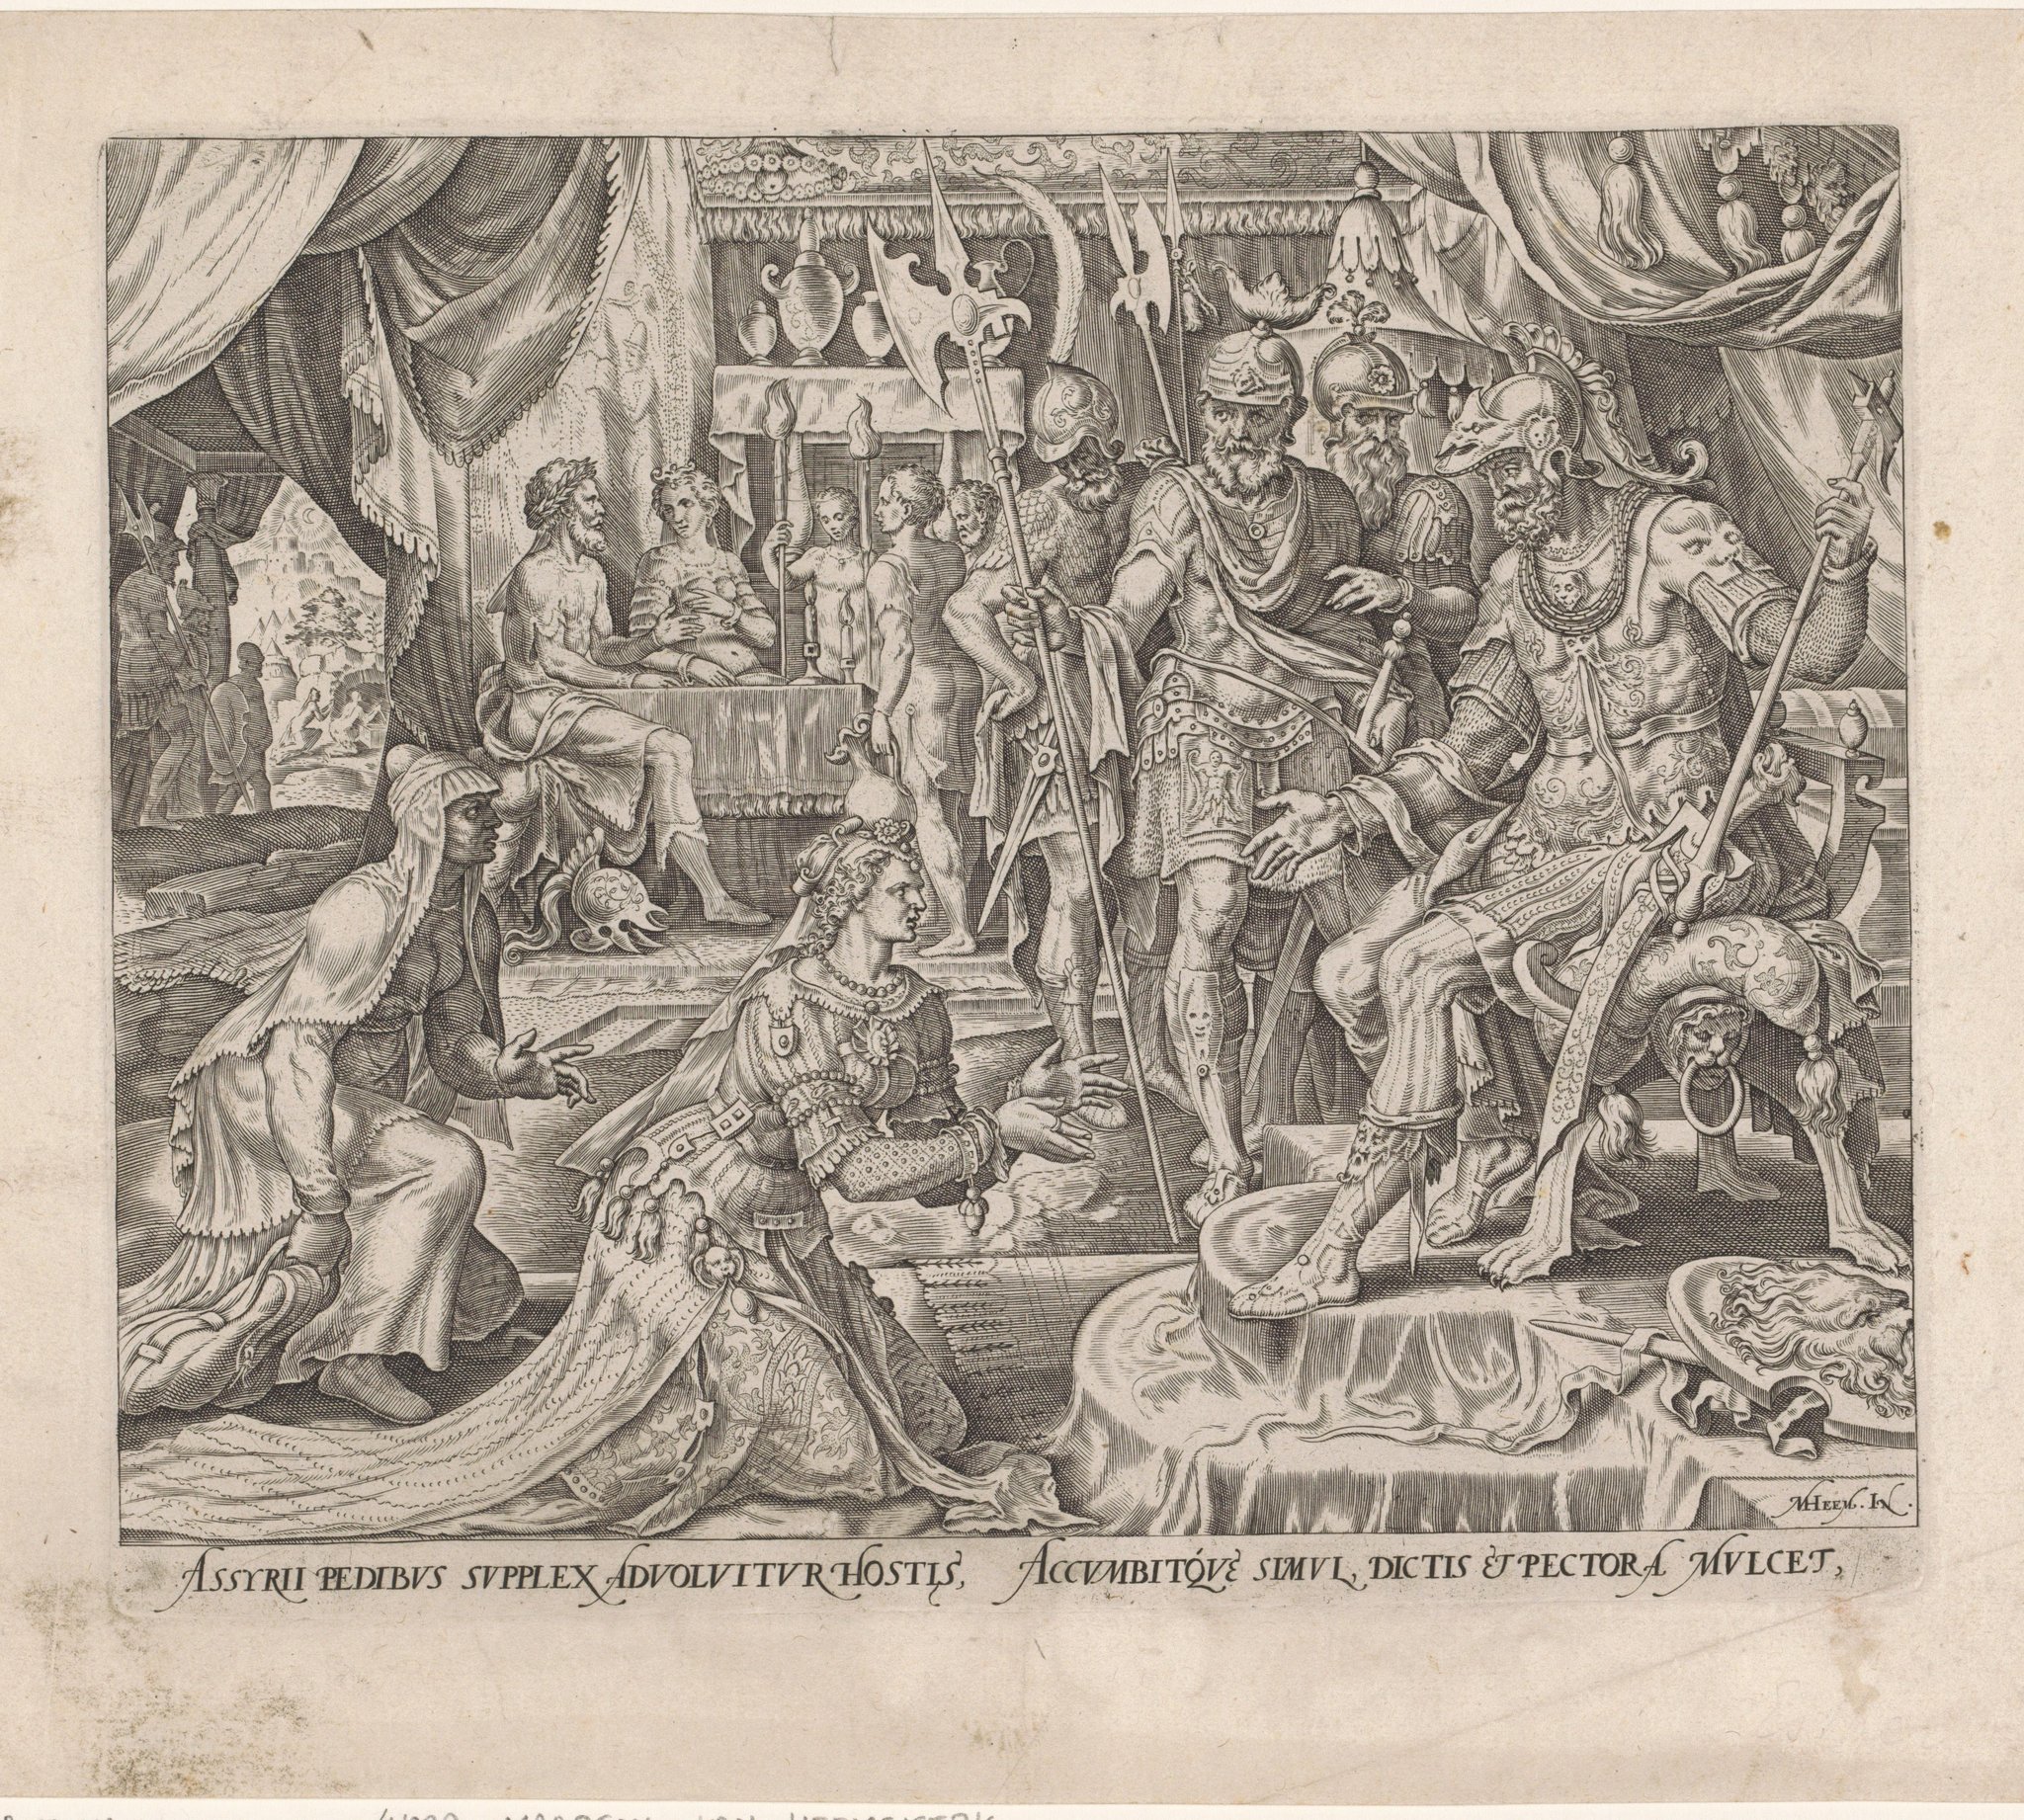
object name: print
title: Geschiedenis van Judith en Holofernes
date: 1564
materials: paper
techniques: engraving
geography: haarlem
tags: judith and holofernes (judith 8-16)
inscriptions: collector's mark: Lugt 2228